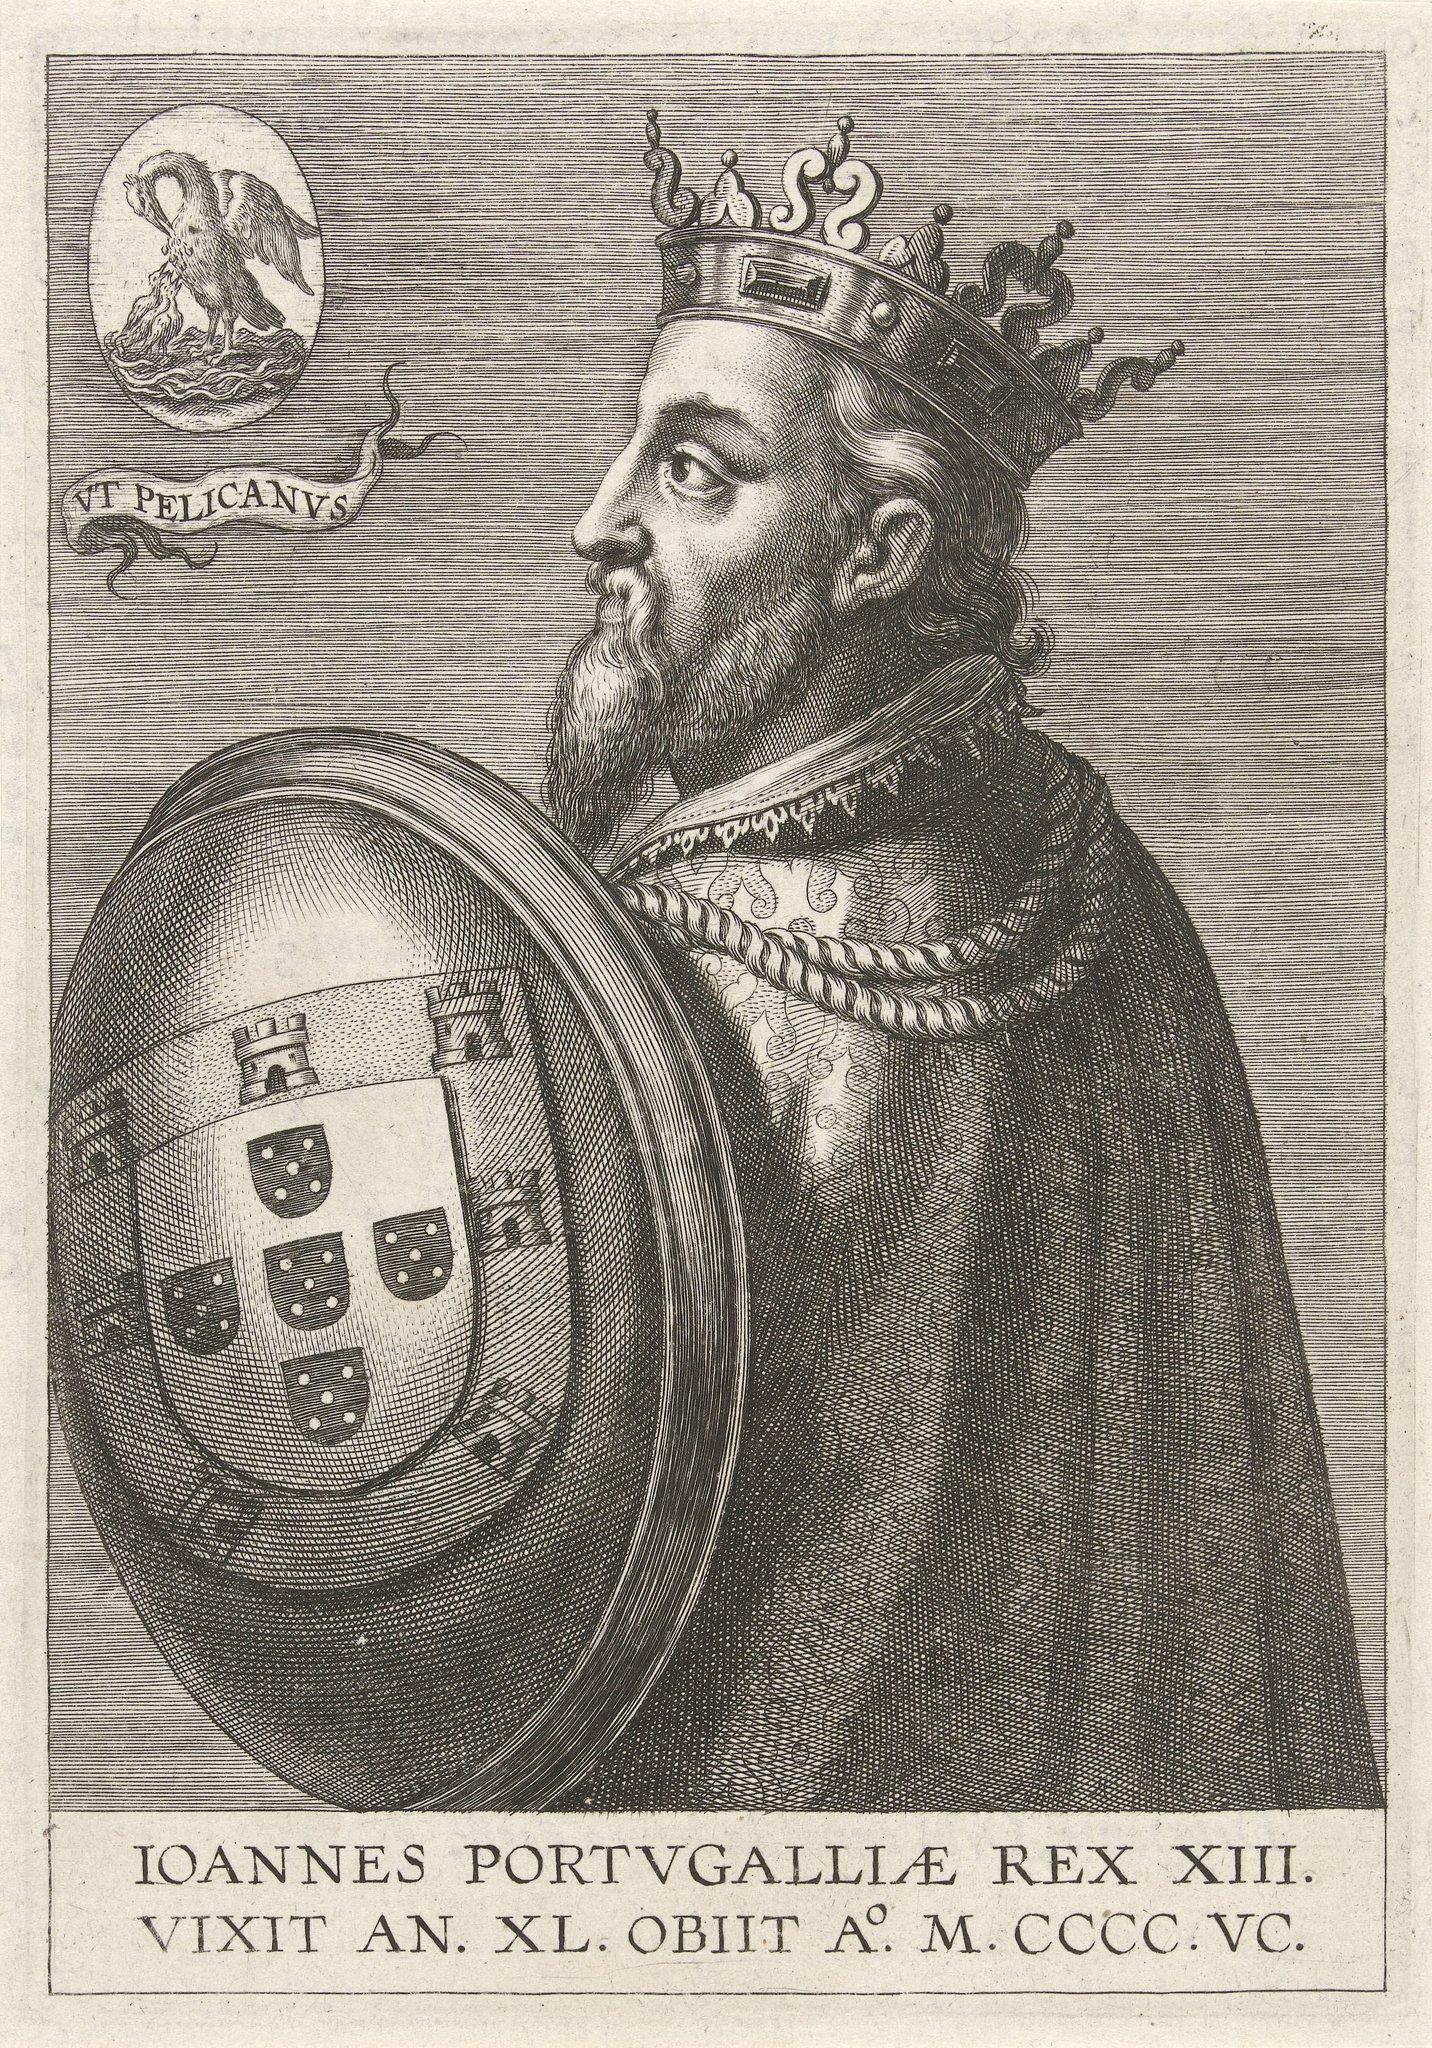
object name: print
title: Koningen en prinsen van Portugal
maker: cornelis galle (i)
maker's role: print maker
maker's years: 1576-1650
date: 1621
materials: paper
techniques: engraving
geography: southern netherlands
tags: koning, johan ii (koning van portugal), portugal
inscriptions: collector's mark: Lugt 2228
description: Illustratie voor: Antonio Vasconcellos. Anacephalæoses id est, Svmma captia actorvm regvm Lvsitaniæ. Antwerpen: Petrus II en Joannes II Bellerus, 1621, of latere druk.